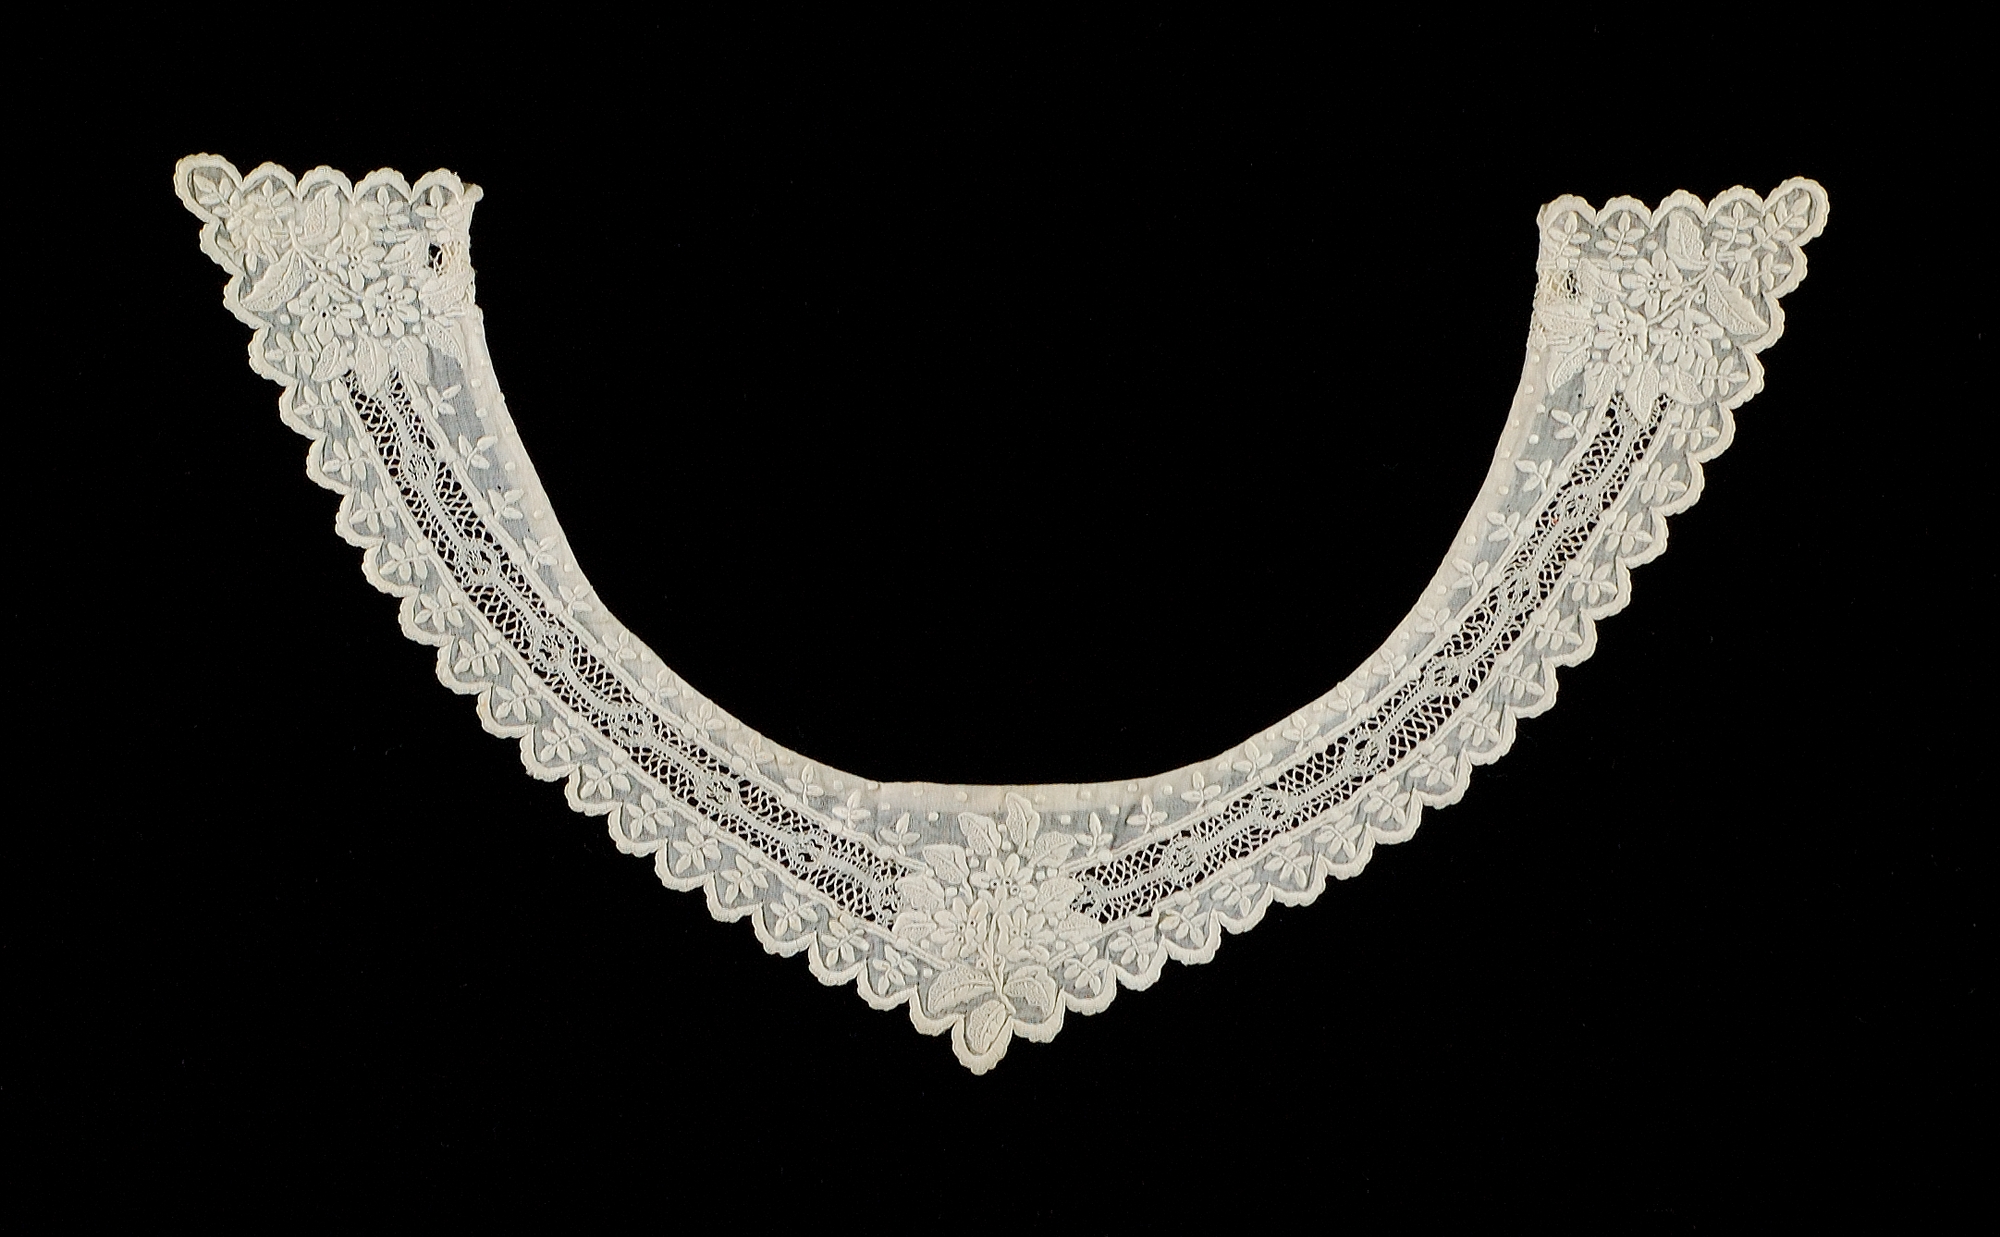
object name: collar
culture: french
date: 1860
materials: cotton, linen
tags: flowers